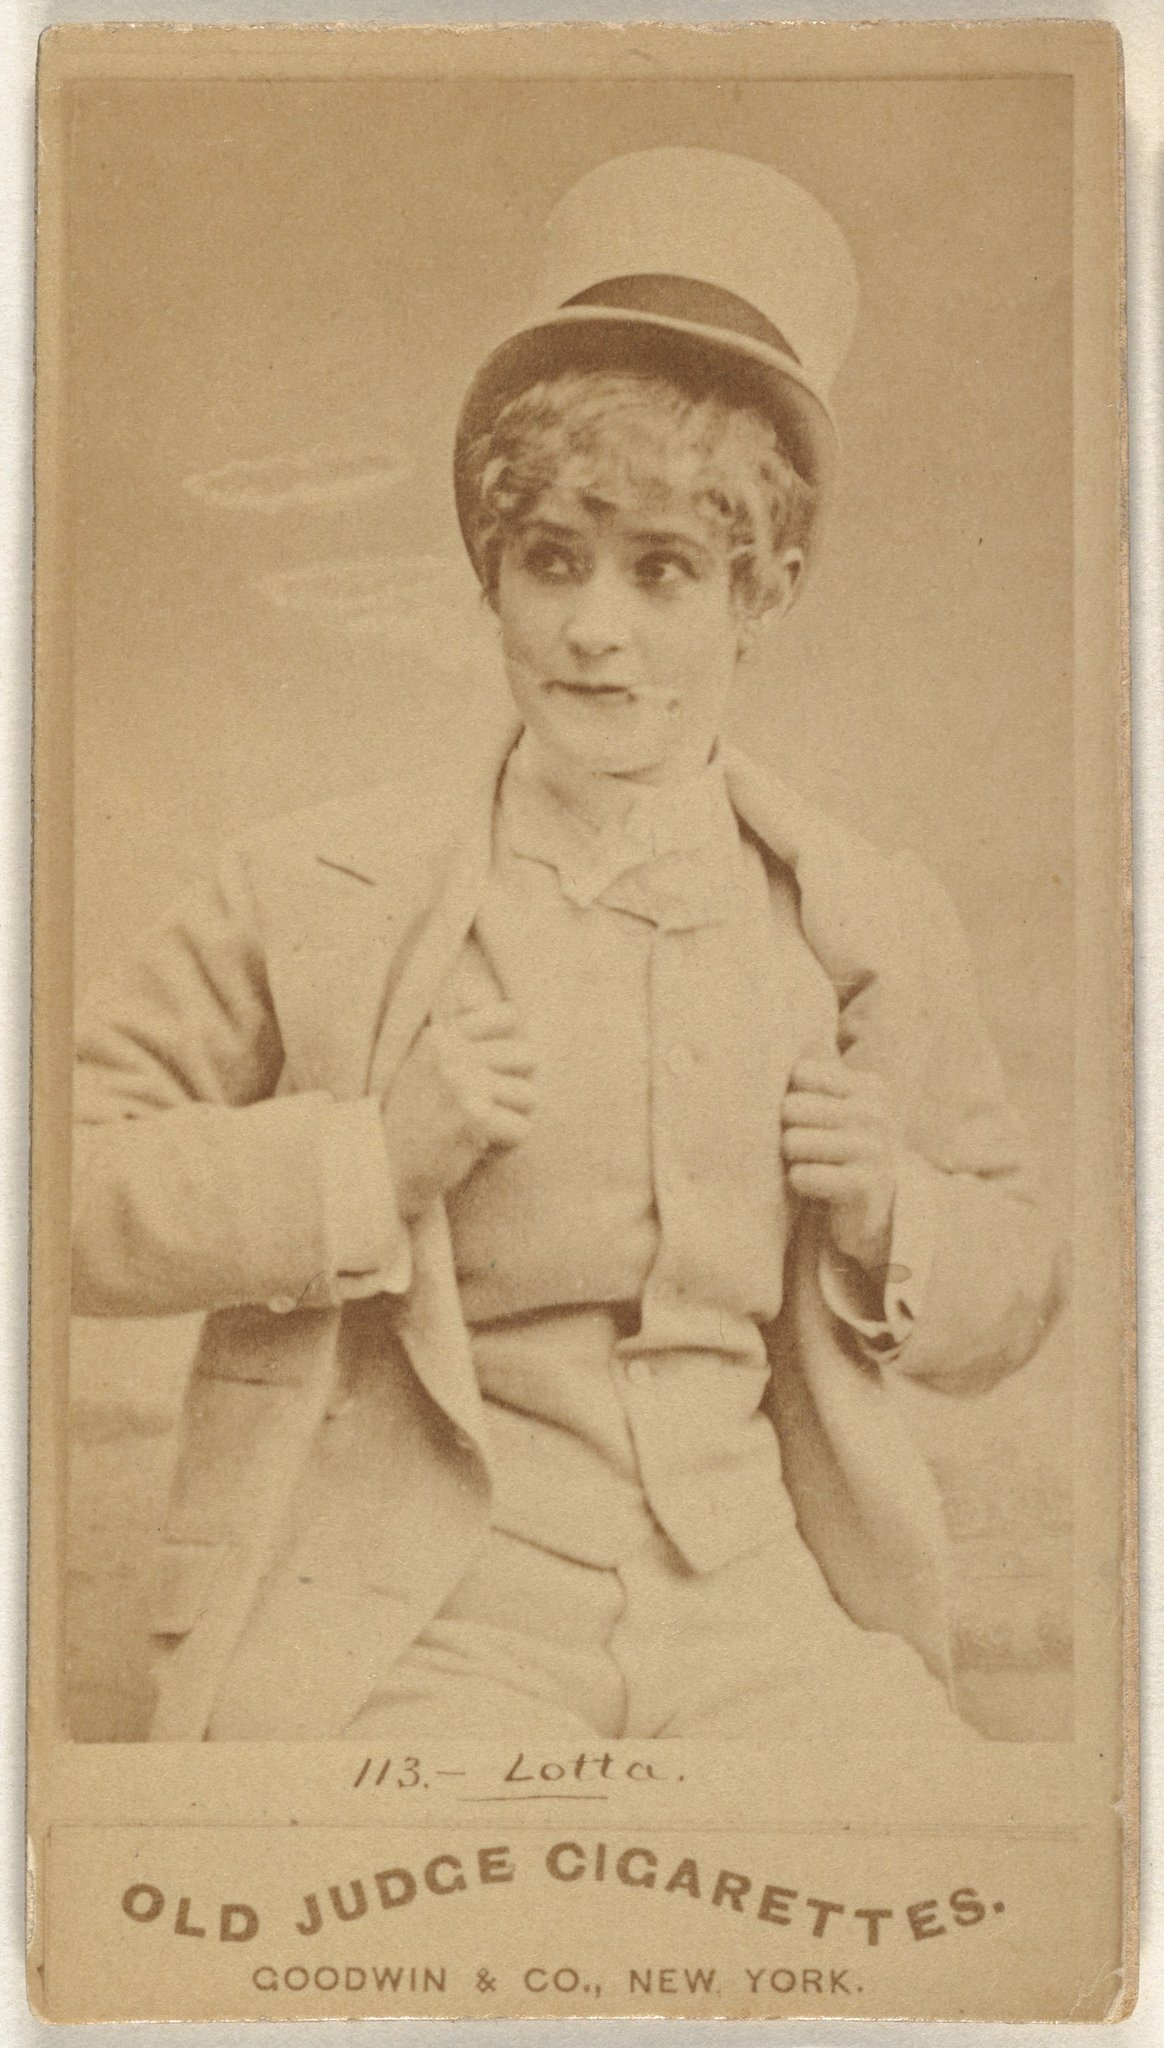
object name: photograph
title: Lotta, from the Actors and Actresses series (N171) for Old Judge Cigarettes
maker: goodwin & company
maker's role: publisher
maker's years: 1850-1950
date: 1886-1890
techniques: albumen silver print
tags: portraits,women,actresses